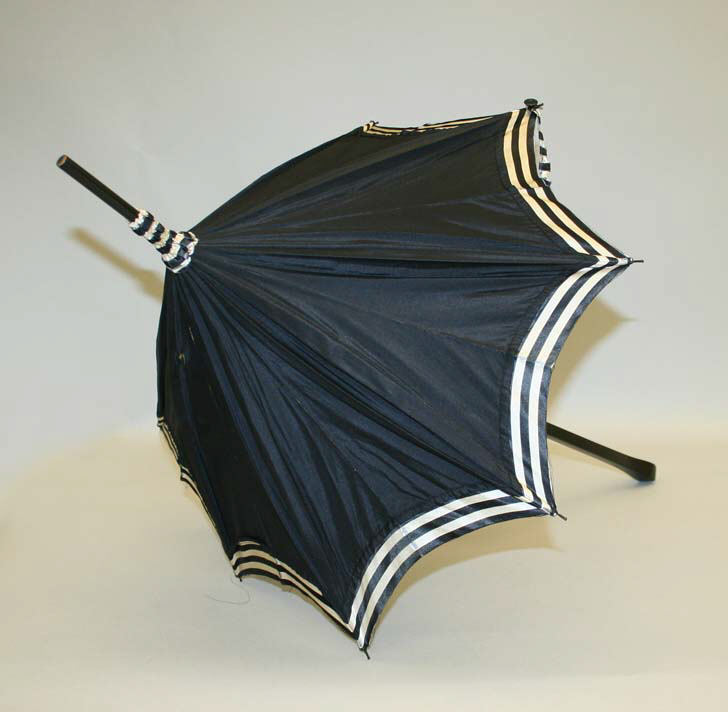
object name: parasol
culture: american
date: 1880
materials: silk